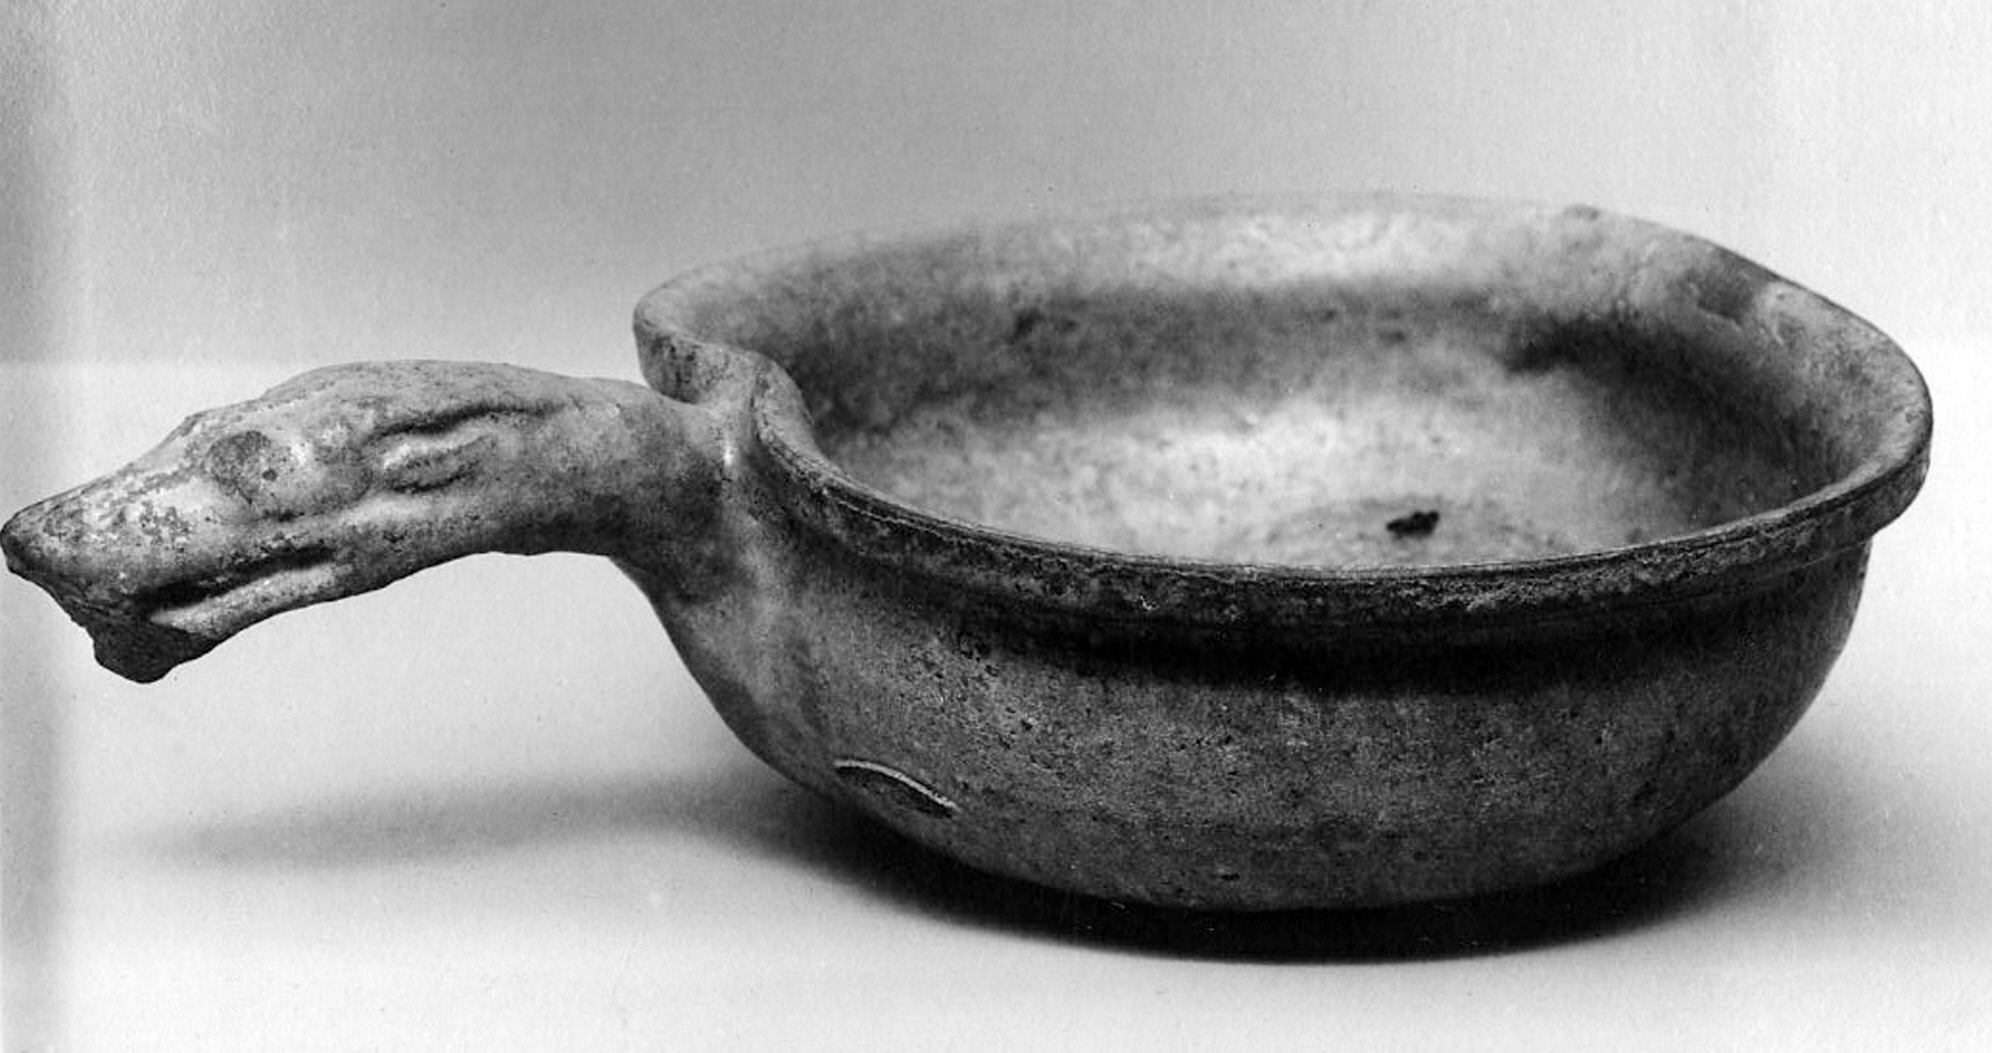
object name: grain scoop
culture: chinese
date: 206 BCE-220 CE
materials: pottery